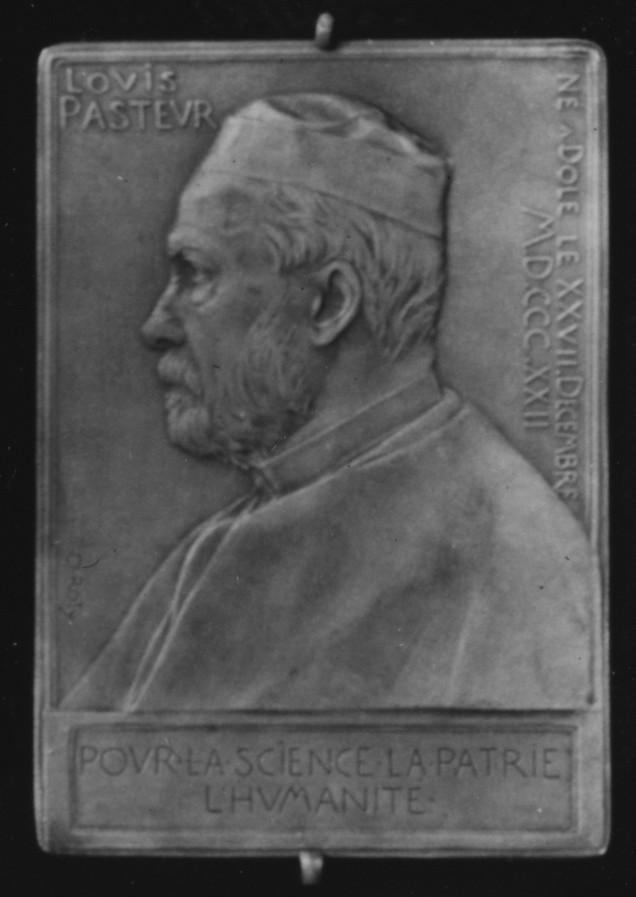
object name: plaquette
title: In Honor of Louis Pasteur, the Great Pathologist, 1892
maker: louis-oscar roty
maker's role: artist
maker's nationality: french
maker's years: 1846-1911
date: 1892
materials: bronze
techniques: silvered, struck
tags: men,profiles,flowers